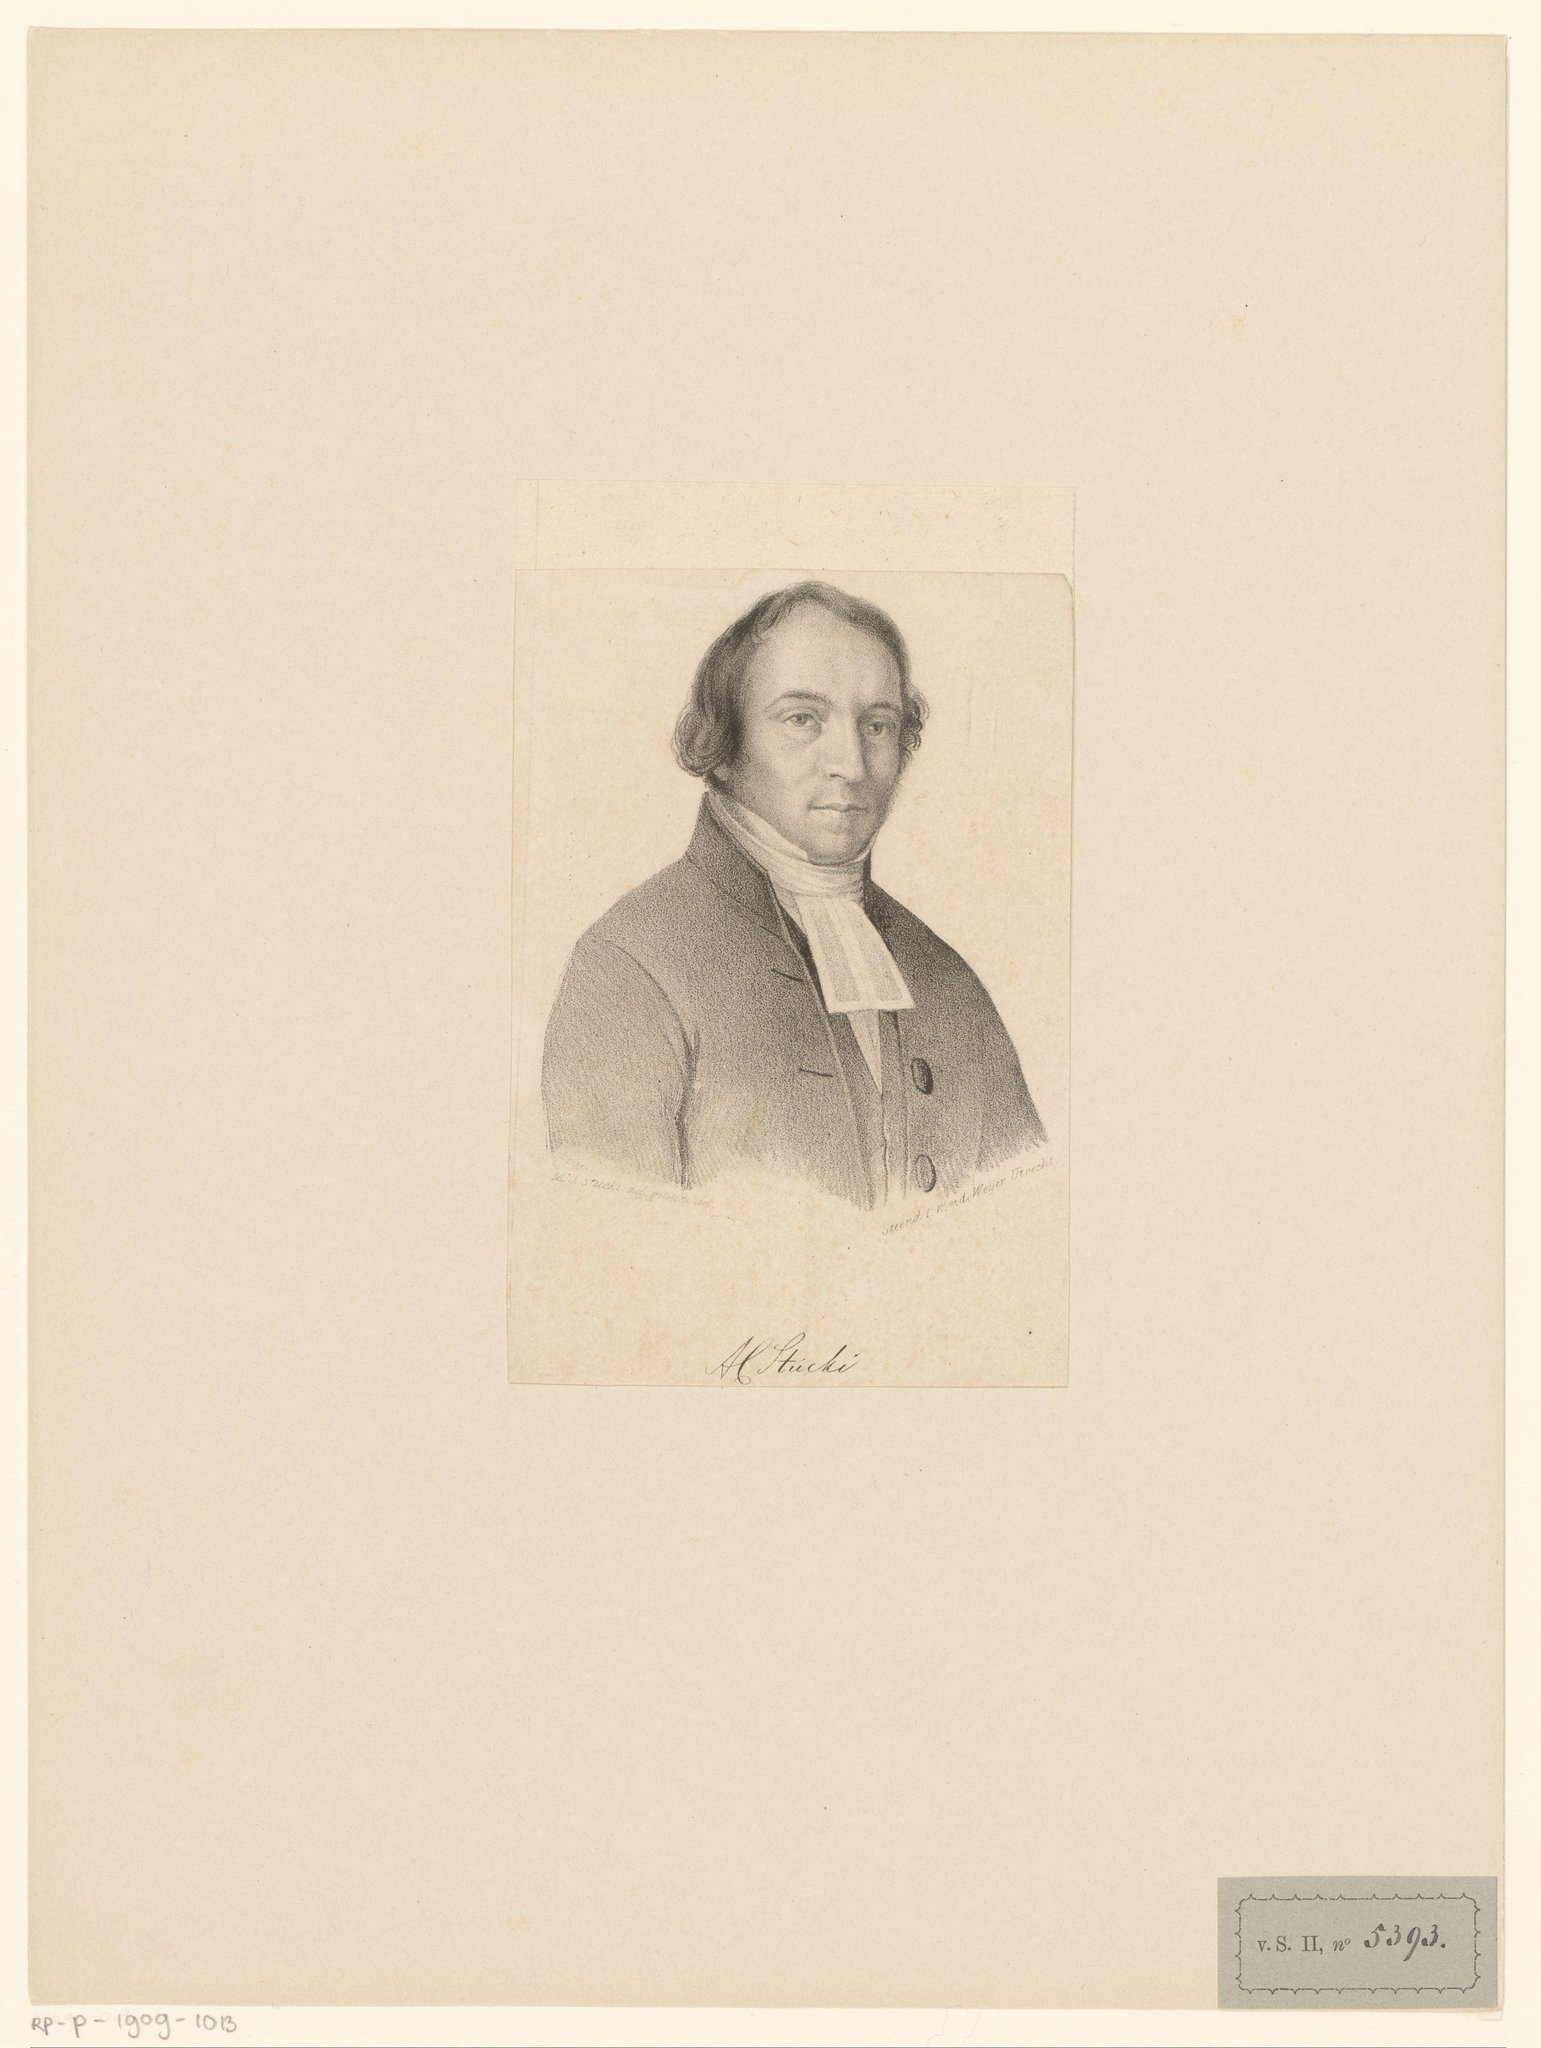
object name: print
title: Portret van Andries Conradus Stucki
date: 1845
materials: paper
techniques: lithograph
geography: utrecht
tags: utrecht, historical persons (+ (full) bust portrait)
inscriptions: collector's mark: Lugt 2228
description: Onder het portret de signatuur van de geportretteerde.